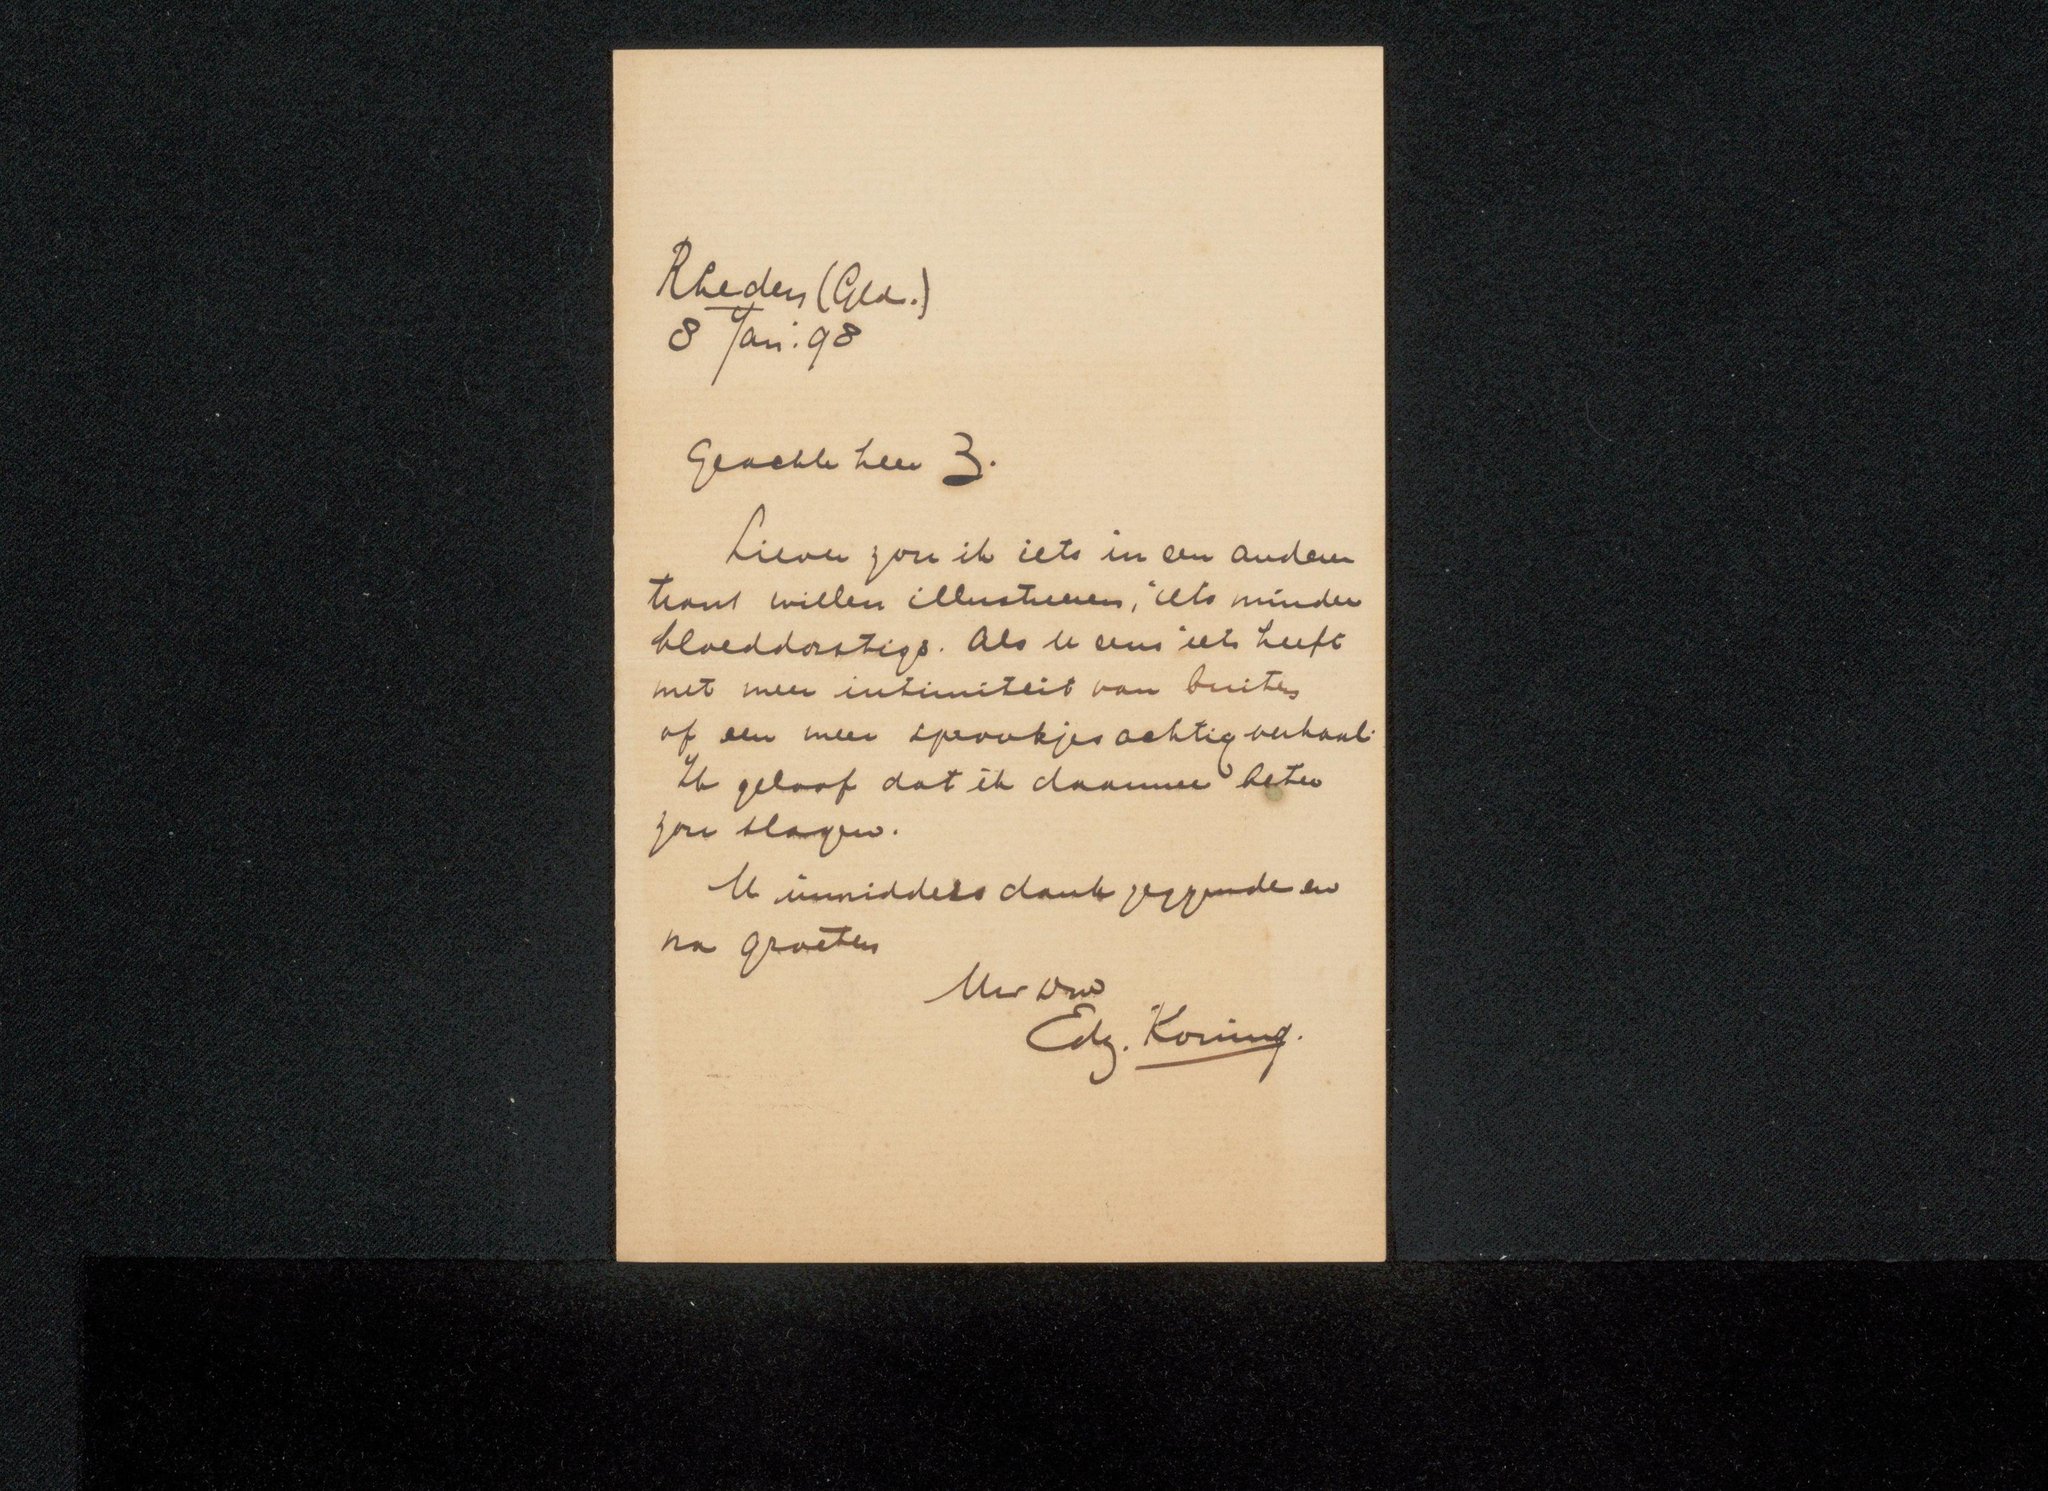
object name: letter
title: Brief aan Philip Zilcken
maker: edzard koning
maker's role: draughtsman, print maker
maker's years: 1869-1954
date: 1898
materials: ink, paper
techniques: pen, writing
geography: rheden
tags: the hague, painter, draughtsman, philip zilcken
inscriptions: collector's mark: ‘RPK’